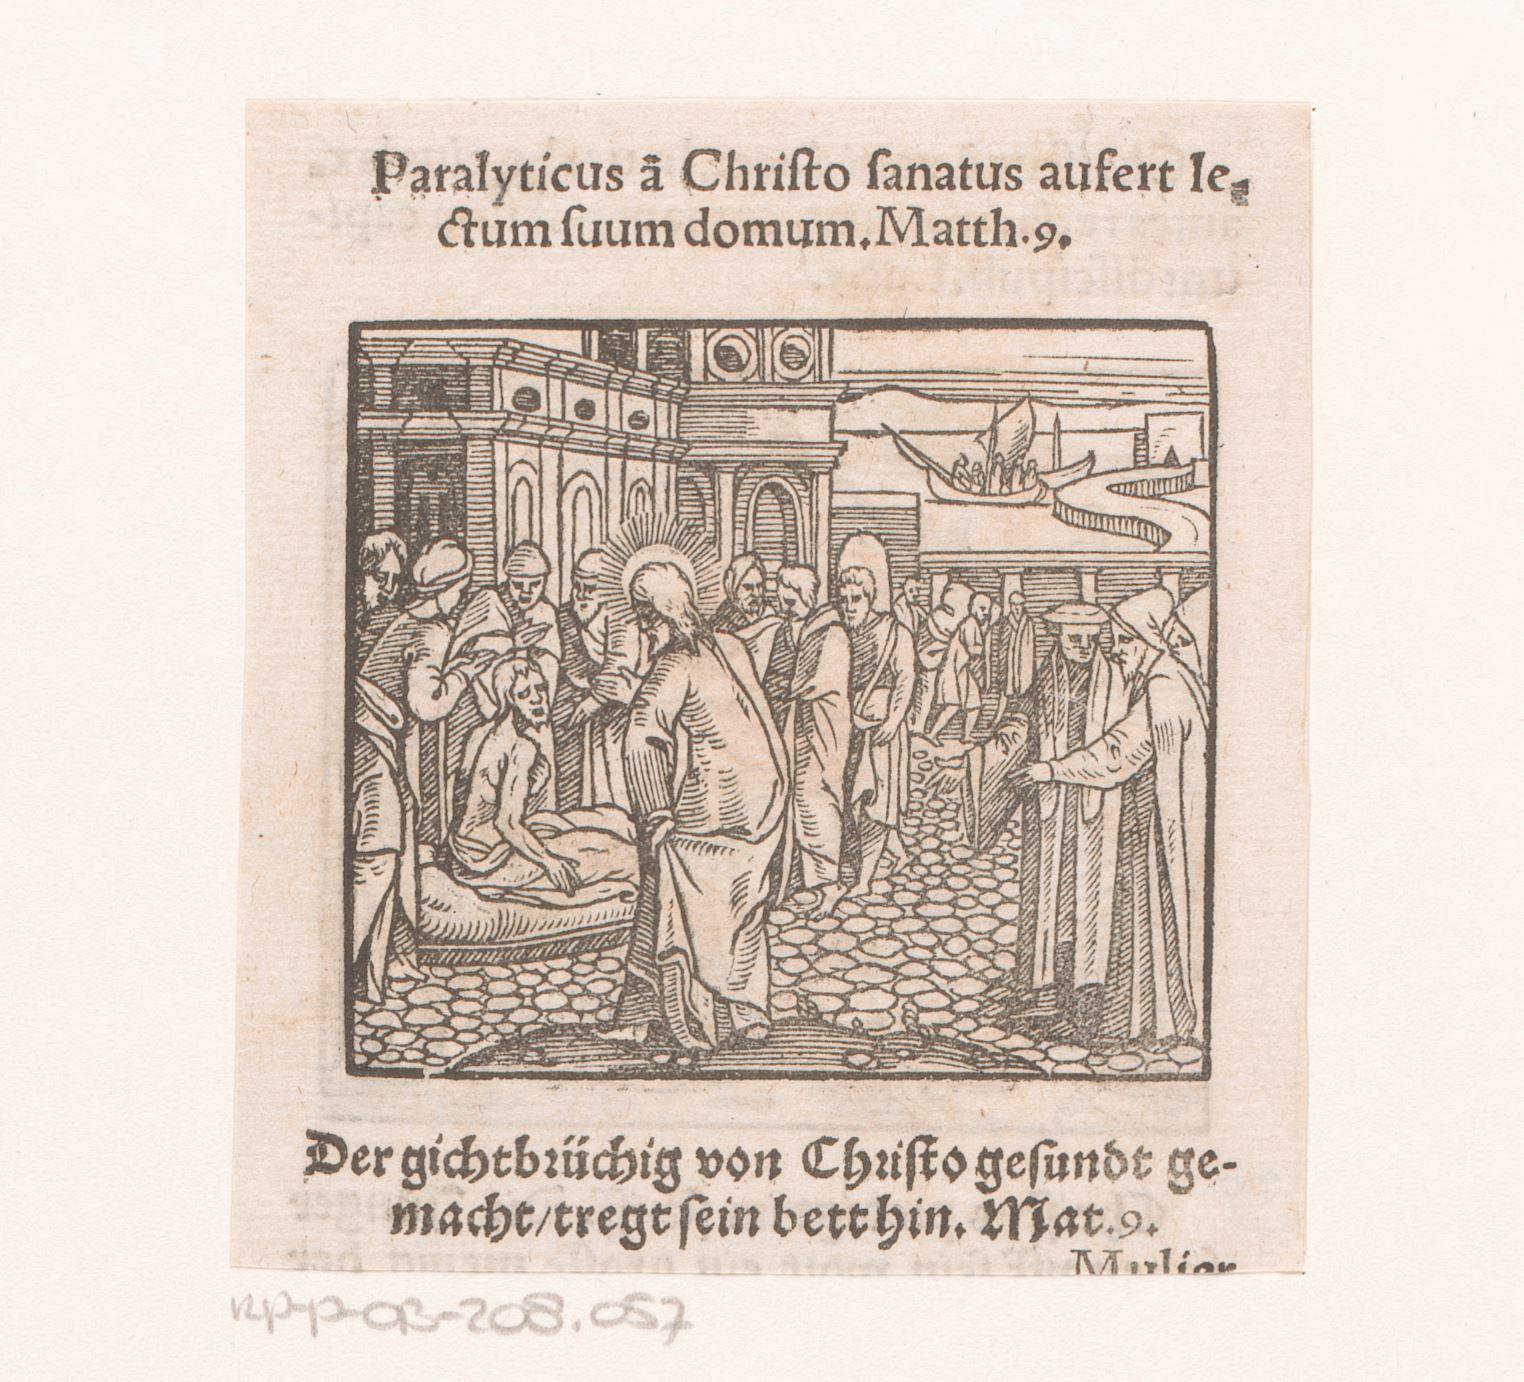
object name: print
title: Christus geneest de verlamde man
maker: Anonymous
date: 1600-1699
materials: paper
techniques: letterpress printing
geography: netherlands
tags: christ healing paralytics